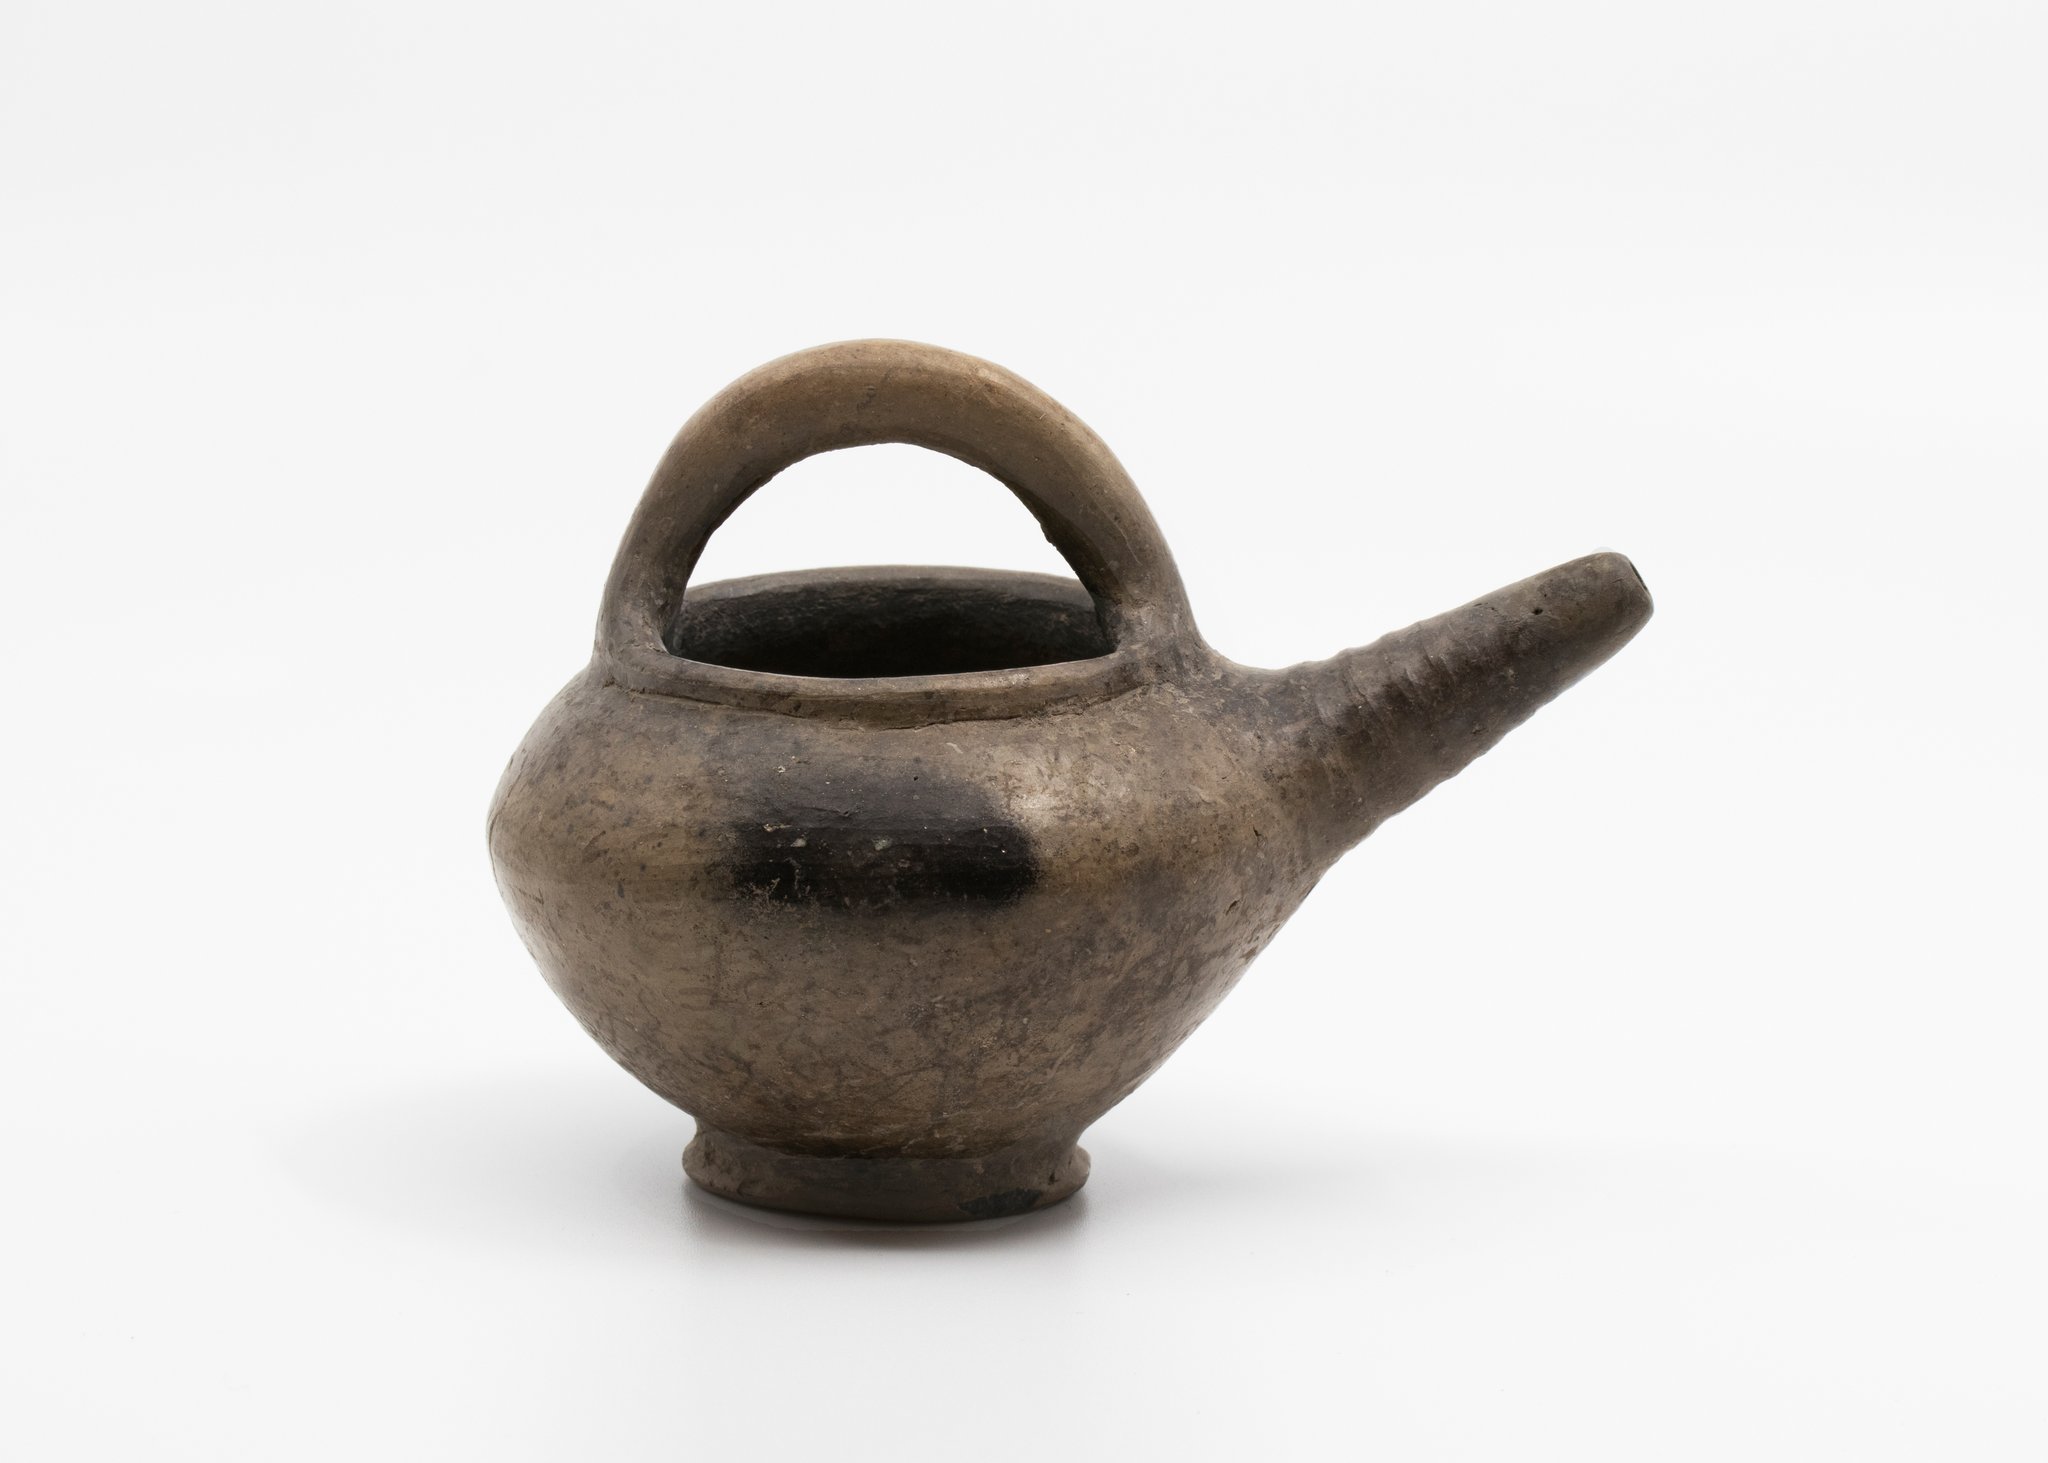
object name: pot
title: Spouted pot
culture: iranian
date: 1050-800 BCE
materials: ceramic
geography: iran